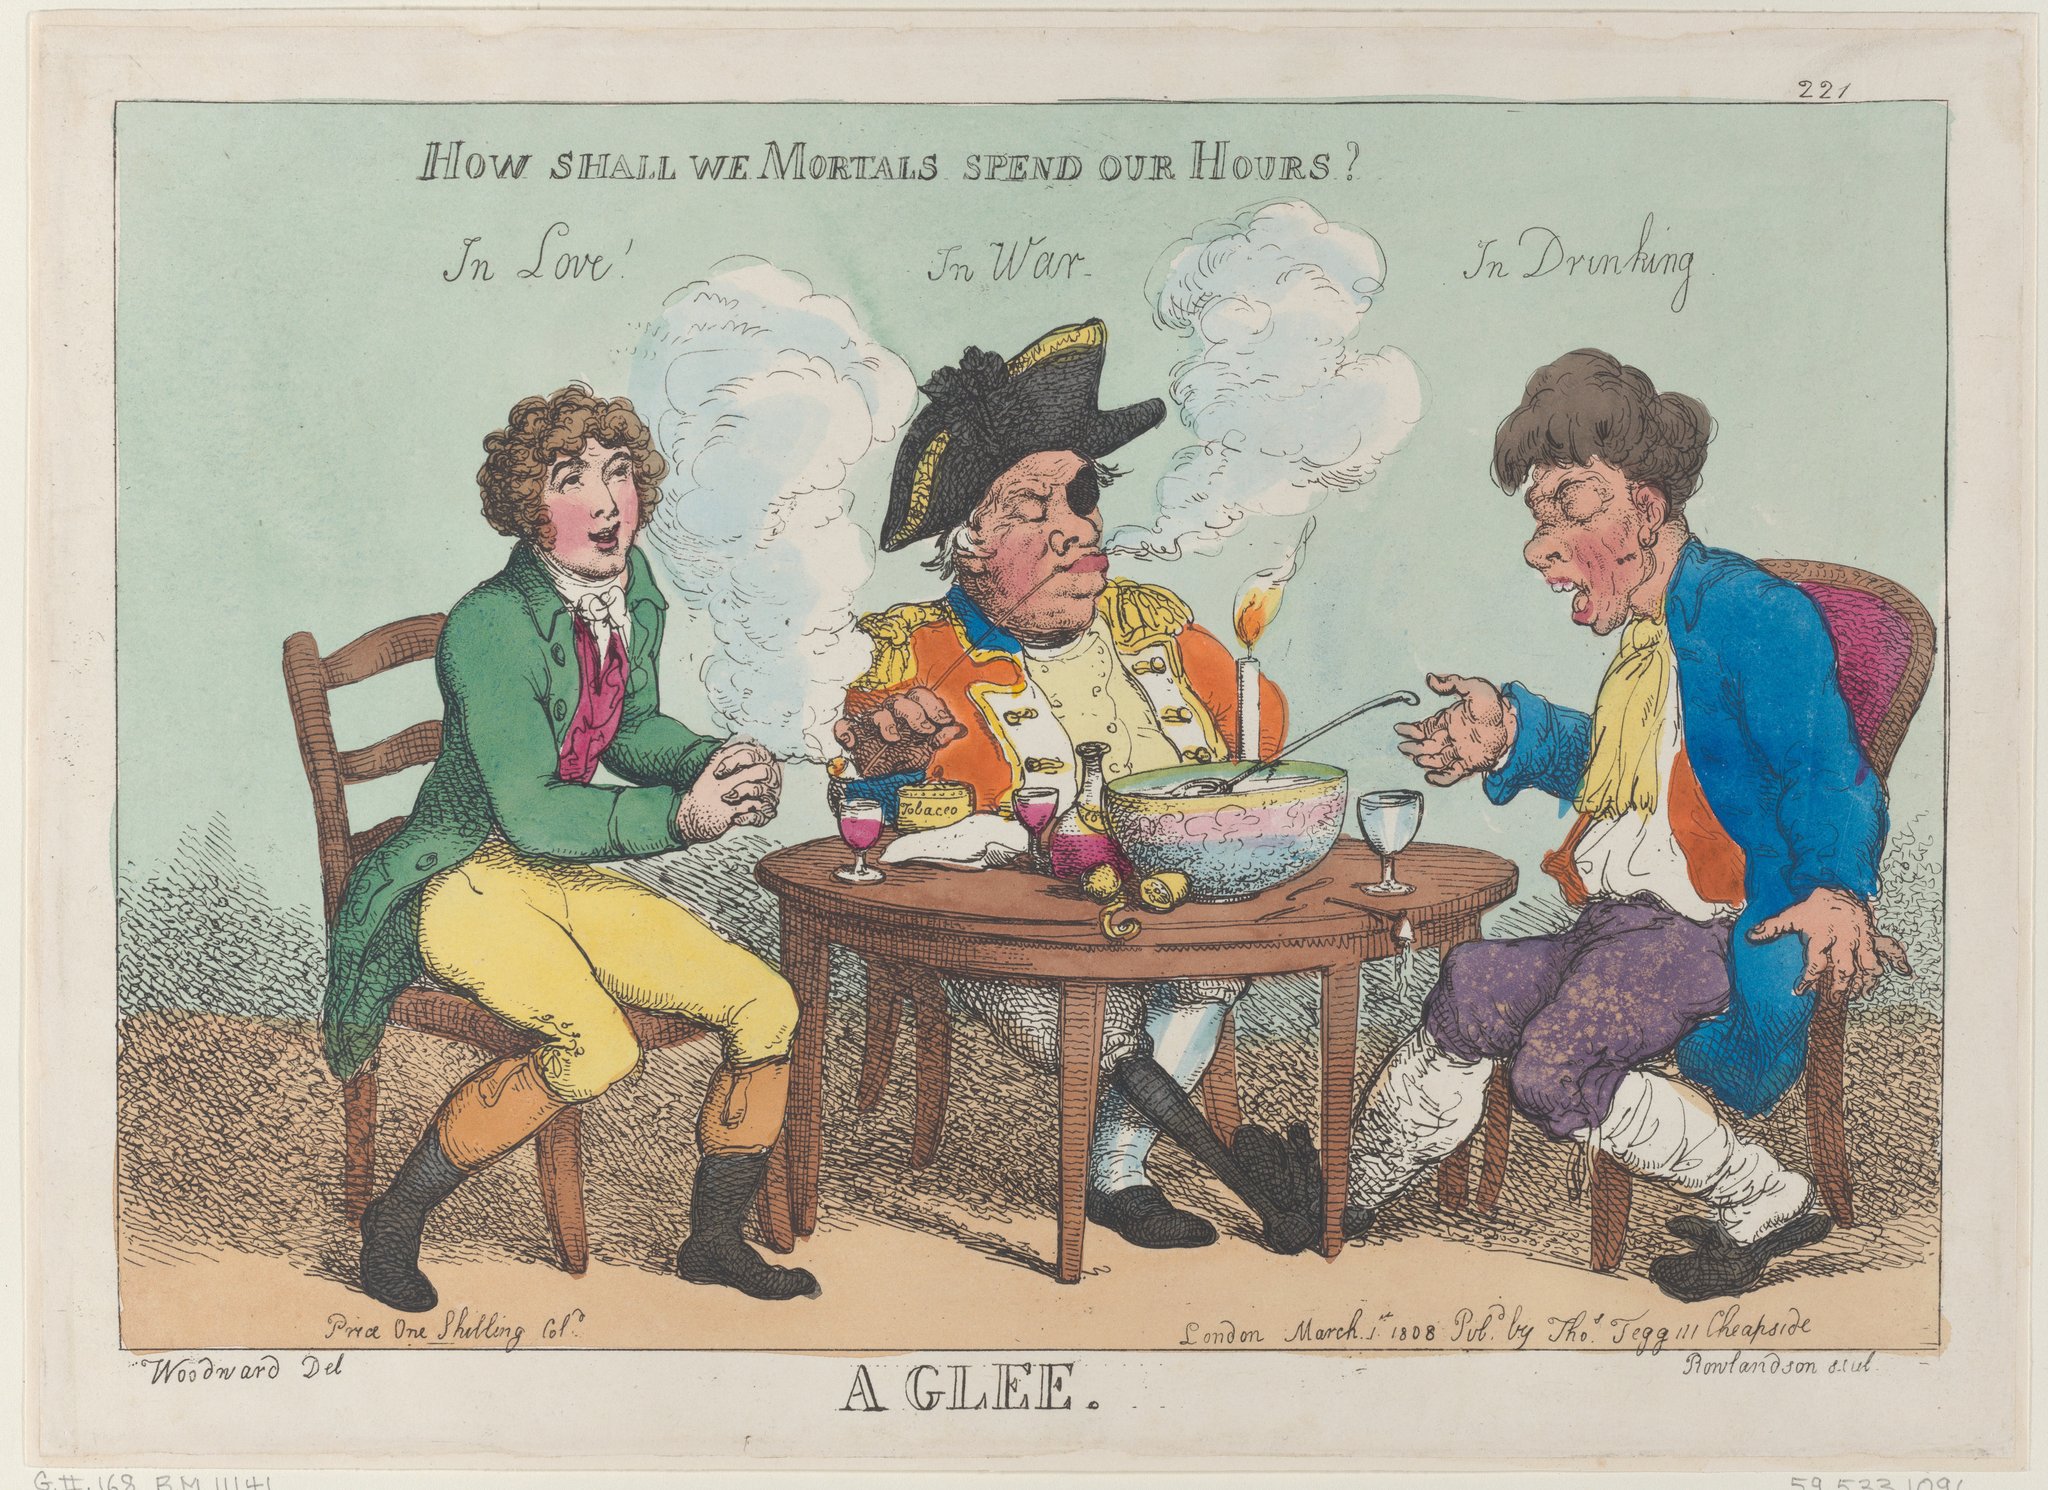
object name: print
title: A Glee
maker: thomas rowlandson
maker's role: artist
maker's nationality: british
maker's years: 1757-1827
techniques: etching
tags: satire,men,smoking